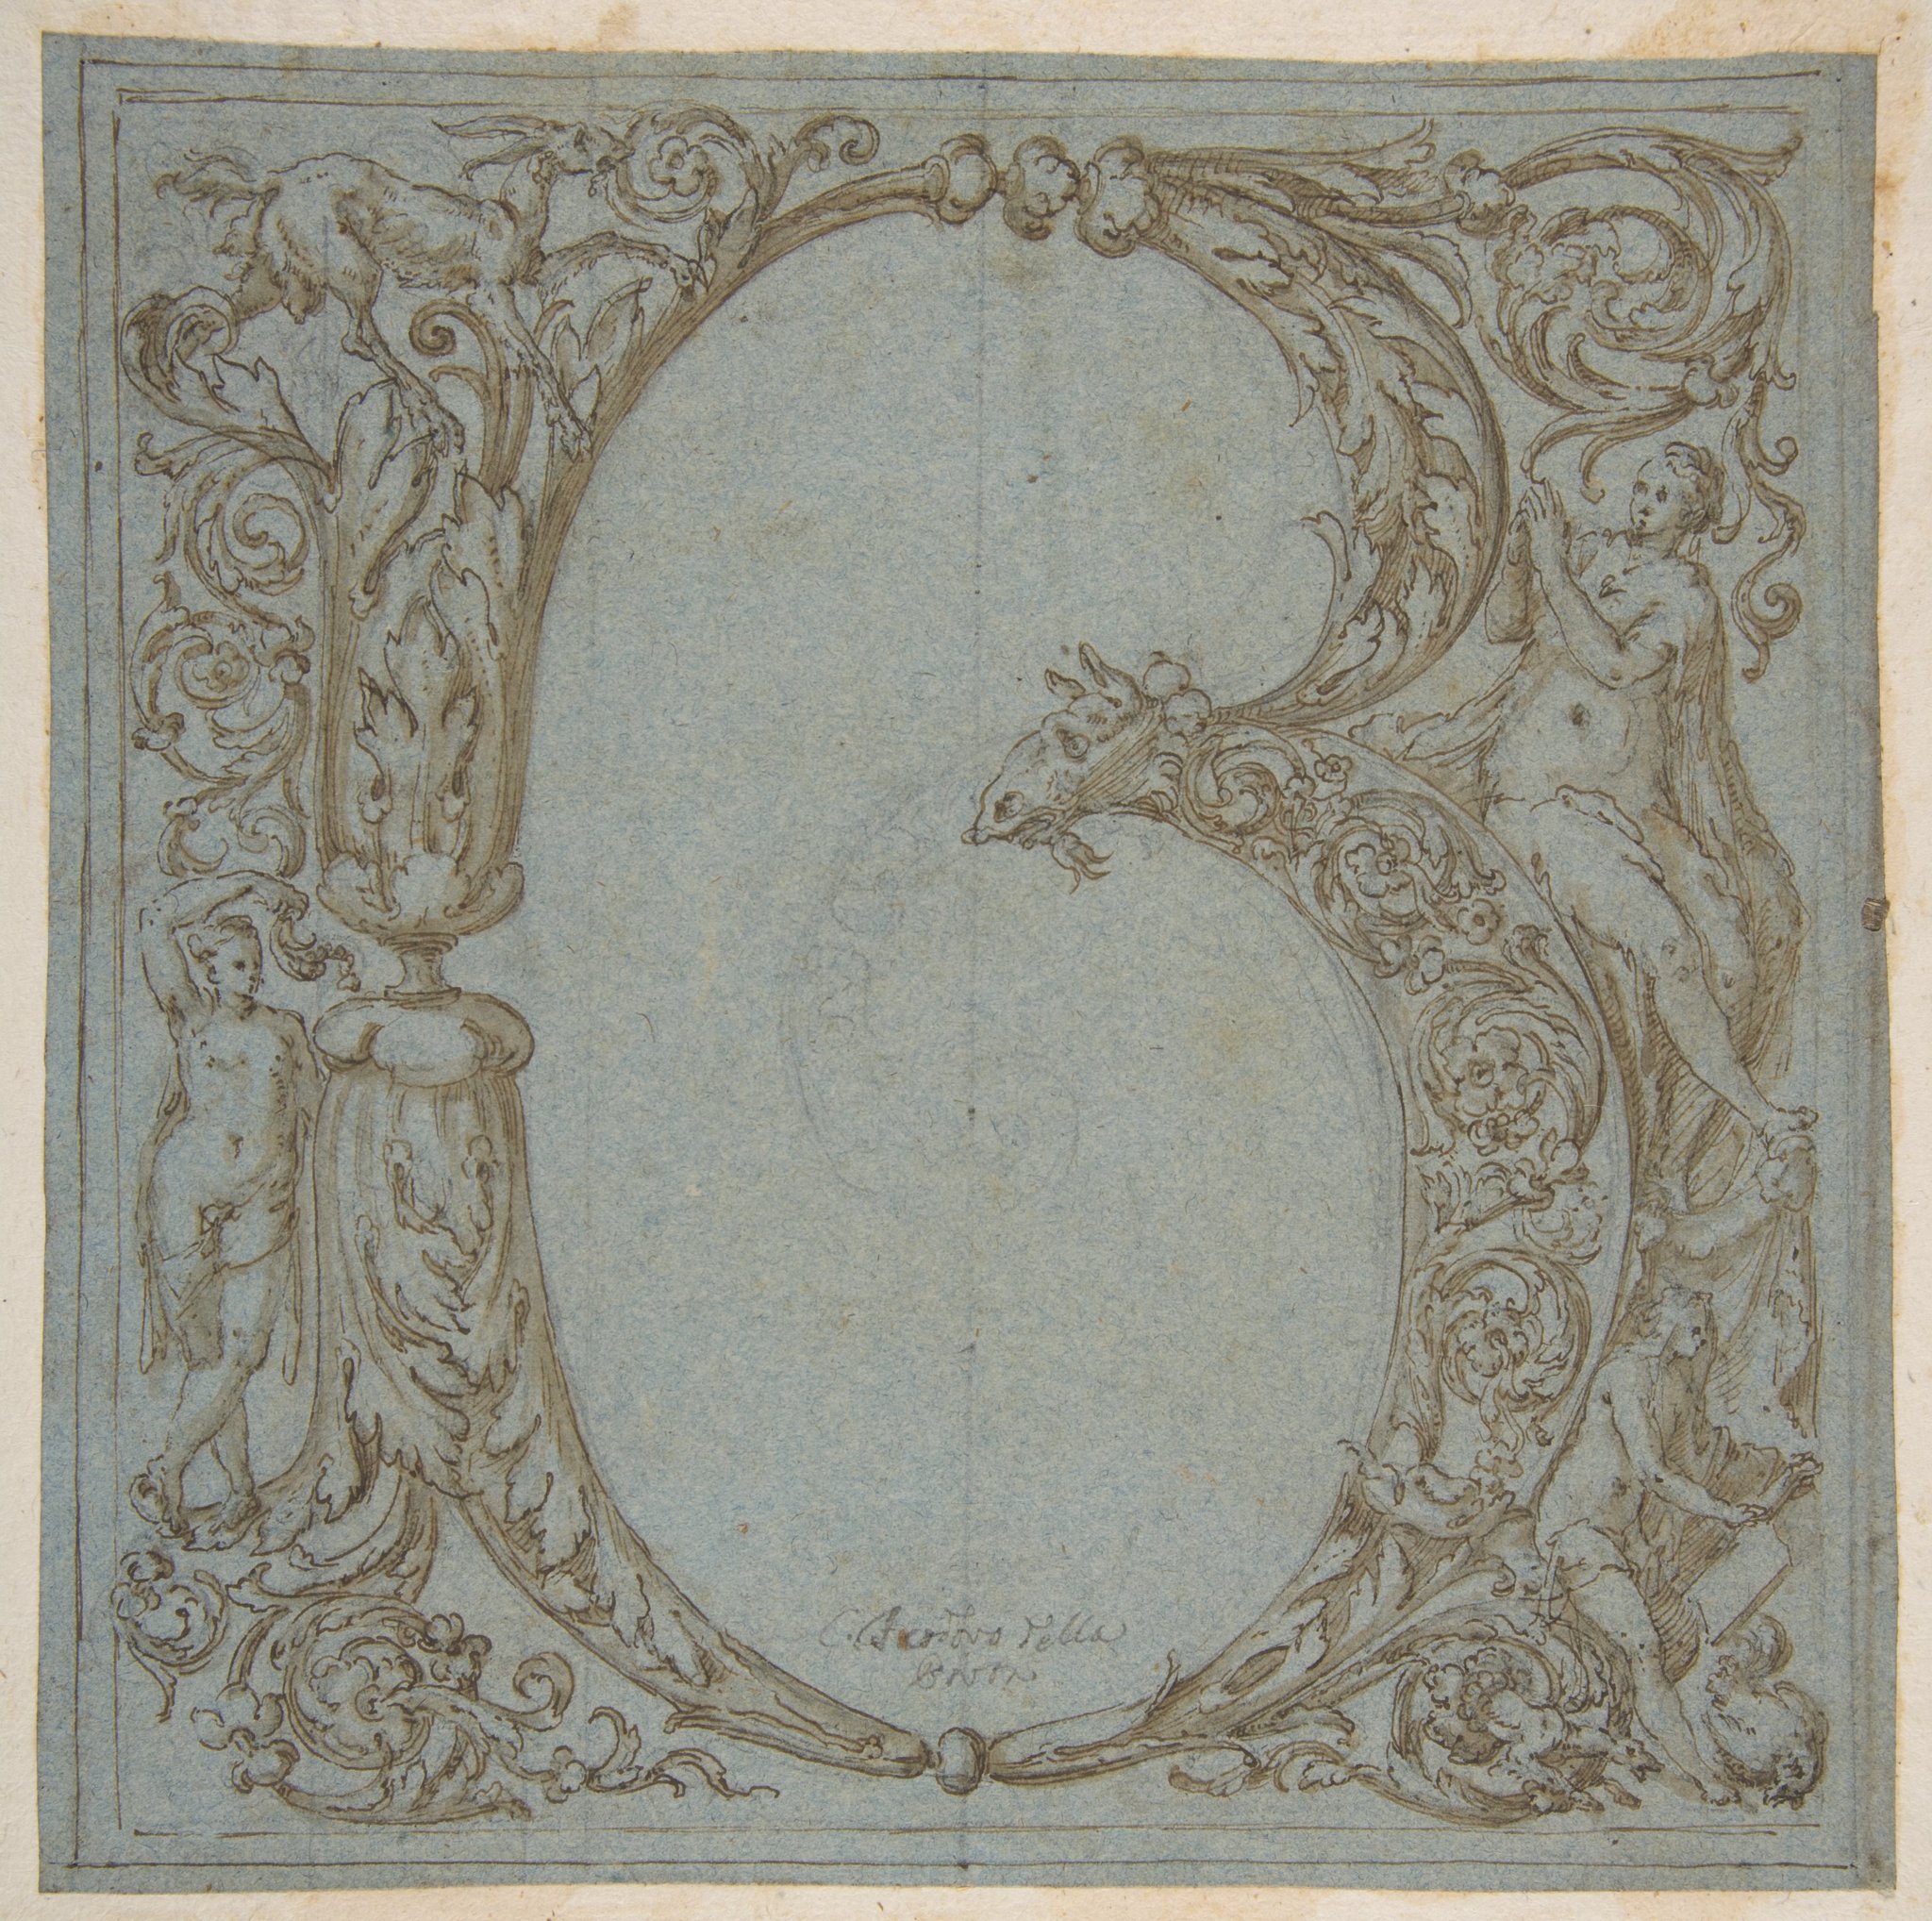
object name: drawing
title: Design for an Ornamental Initial: B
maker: teodoro della porta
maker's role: artist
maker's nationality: italian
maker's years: 1567-1638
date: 1567-1638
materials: chalk, ink, paper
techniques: pen, wash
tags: animals,ornament,female nudes